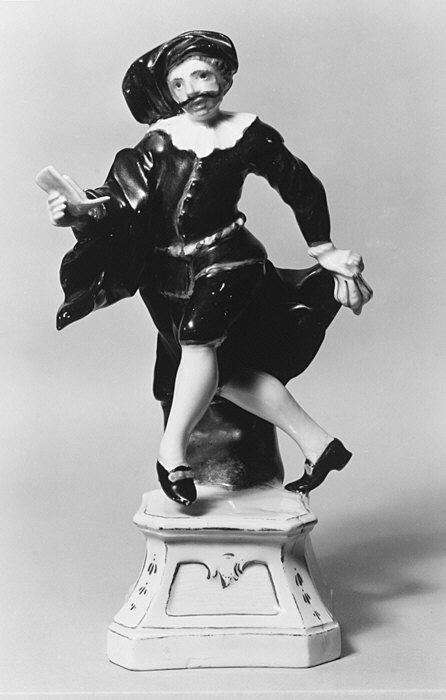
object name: figure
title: Scaramouche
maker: höchst manufactory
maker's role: manufactory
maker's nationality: german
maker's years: 1746-1796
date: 1752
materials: hard paste porcelain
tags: men